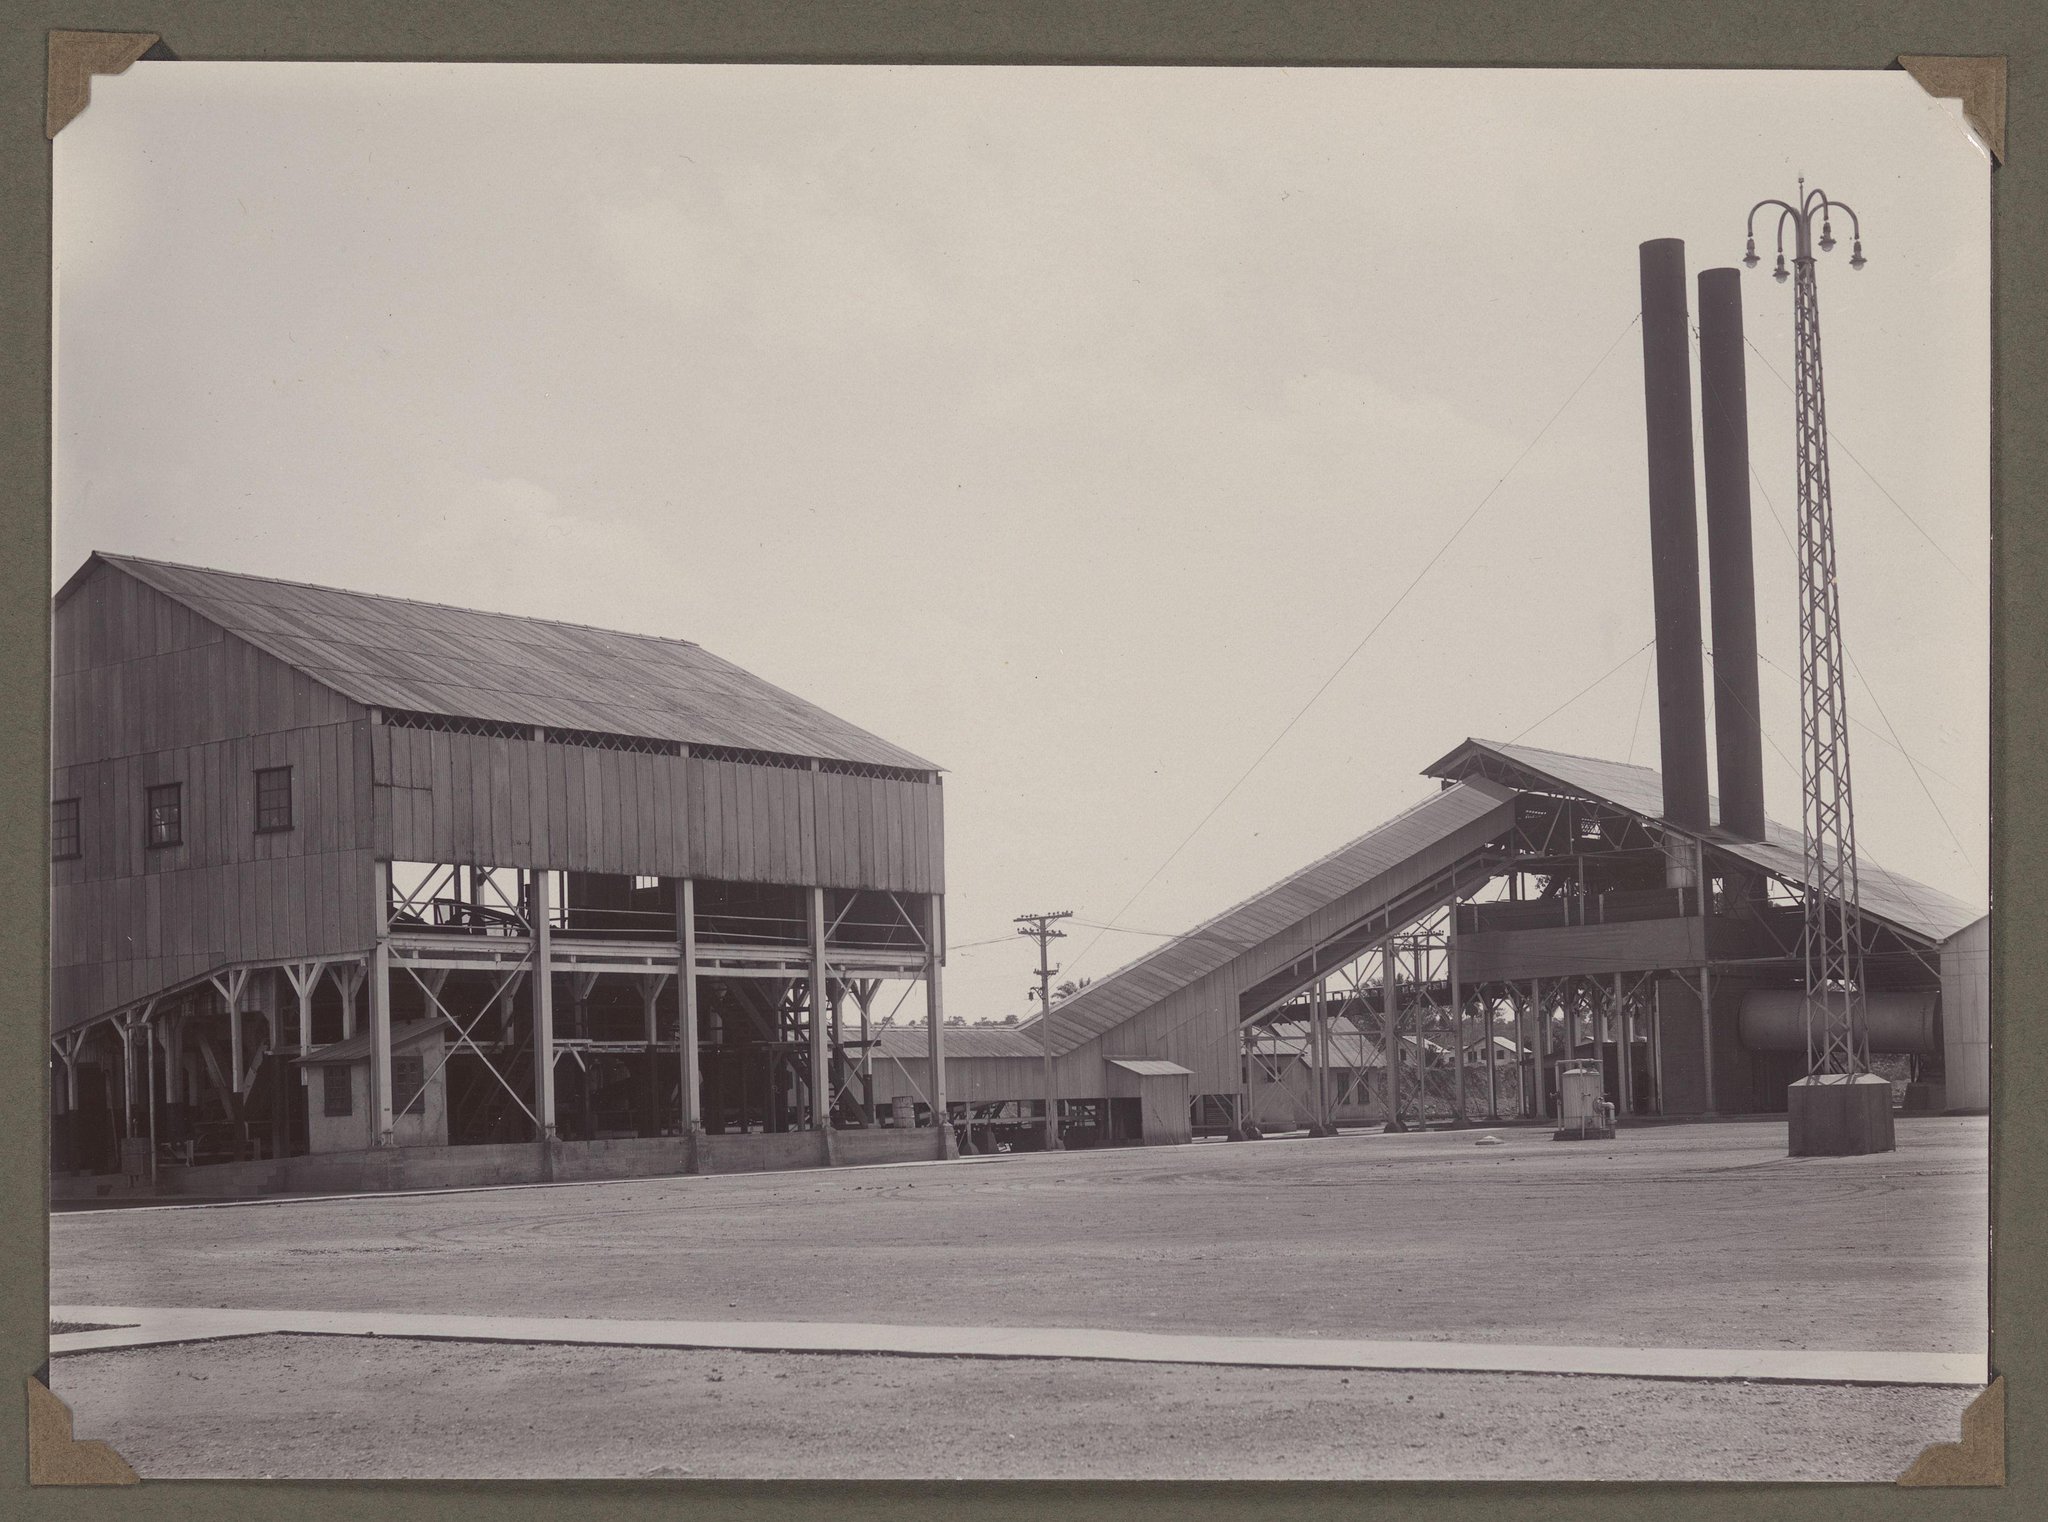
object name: photograph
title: Mijn en fabriek te Moengo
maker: Anonymous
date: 1925-1927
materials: photographic support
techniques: photography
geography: suriname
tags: jetten, familie, moengo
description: De mijn en fabriek te Moengo. Foto op een bladzijde van een los albumblad. Onderdeel van het ensemble met foto's van de familie van ingenieur Jetten in de mijnbouwstad Moengo in Suriname.